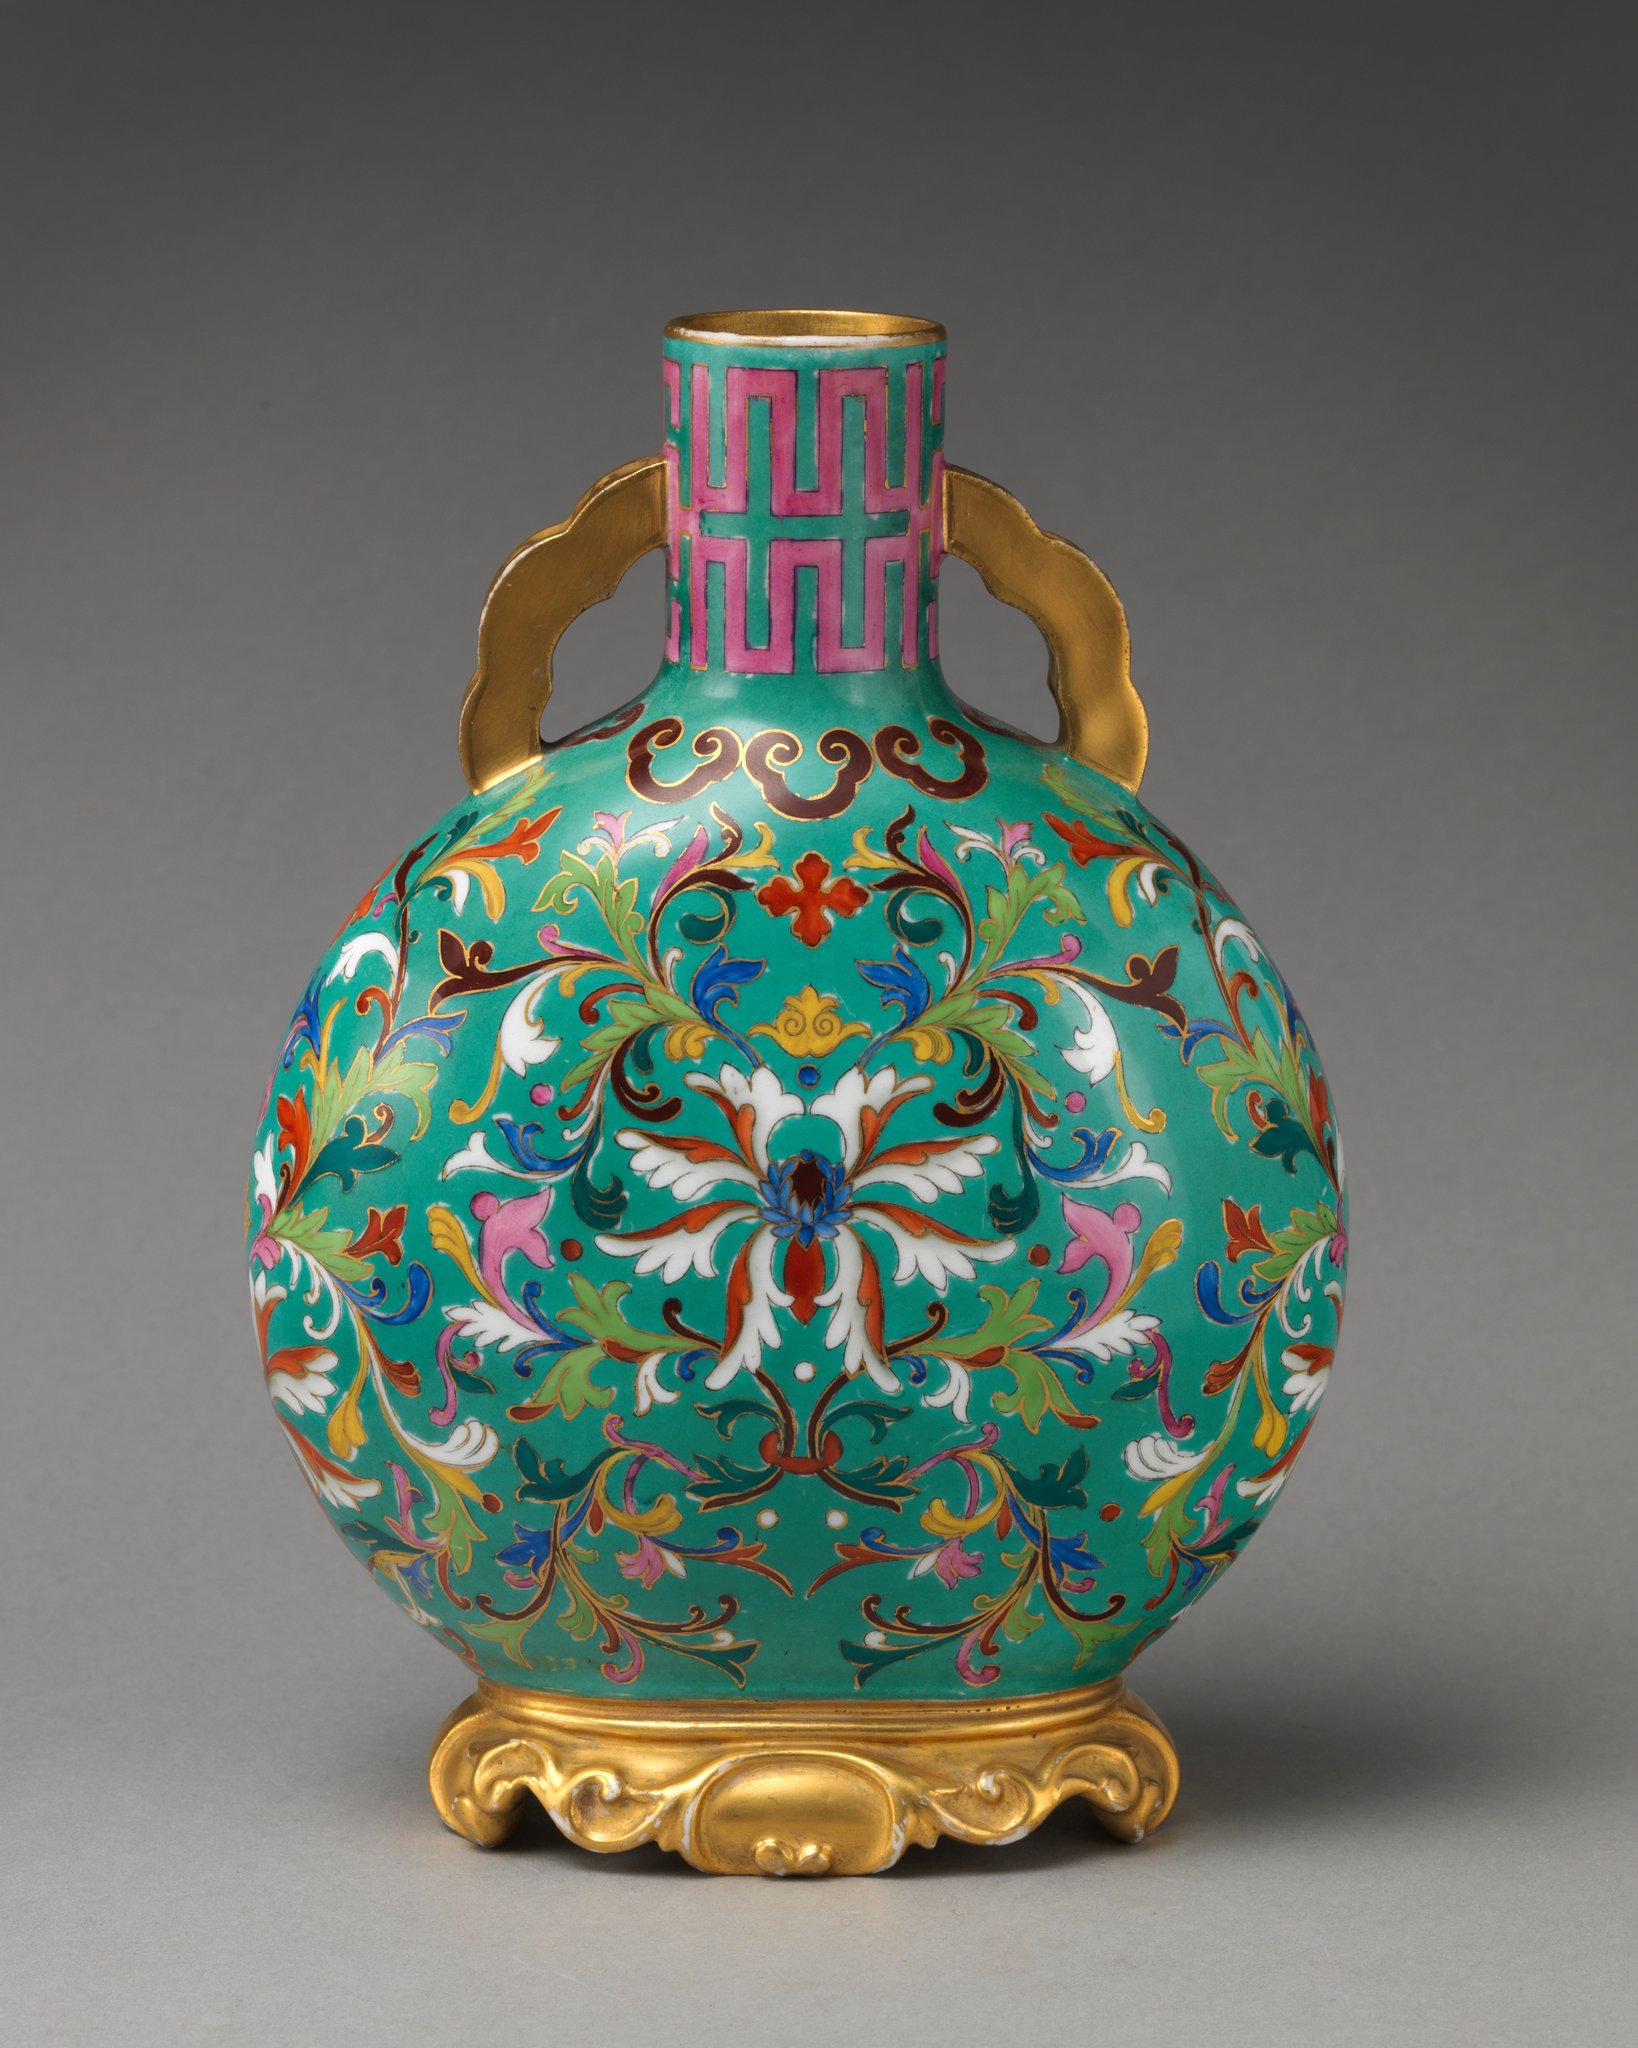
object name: moon flask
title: Moon flask (one of a pair)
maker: worcester factory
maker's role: maker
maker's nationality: british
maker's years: 1751-2008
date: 1870-1879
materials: bone china